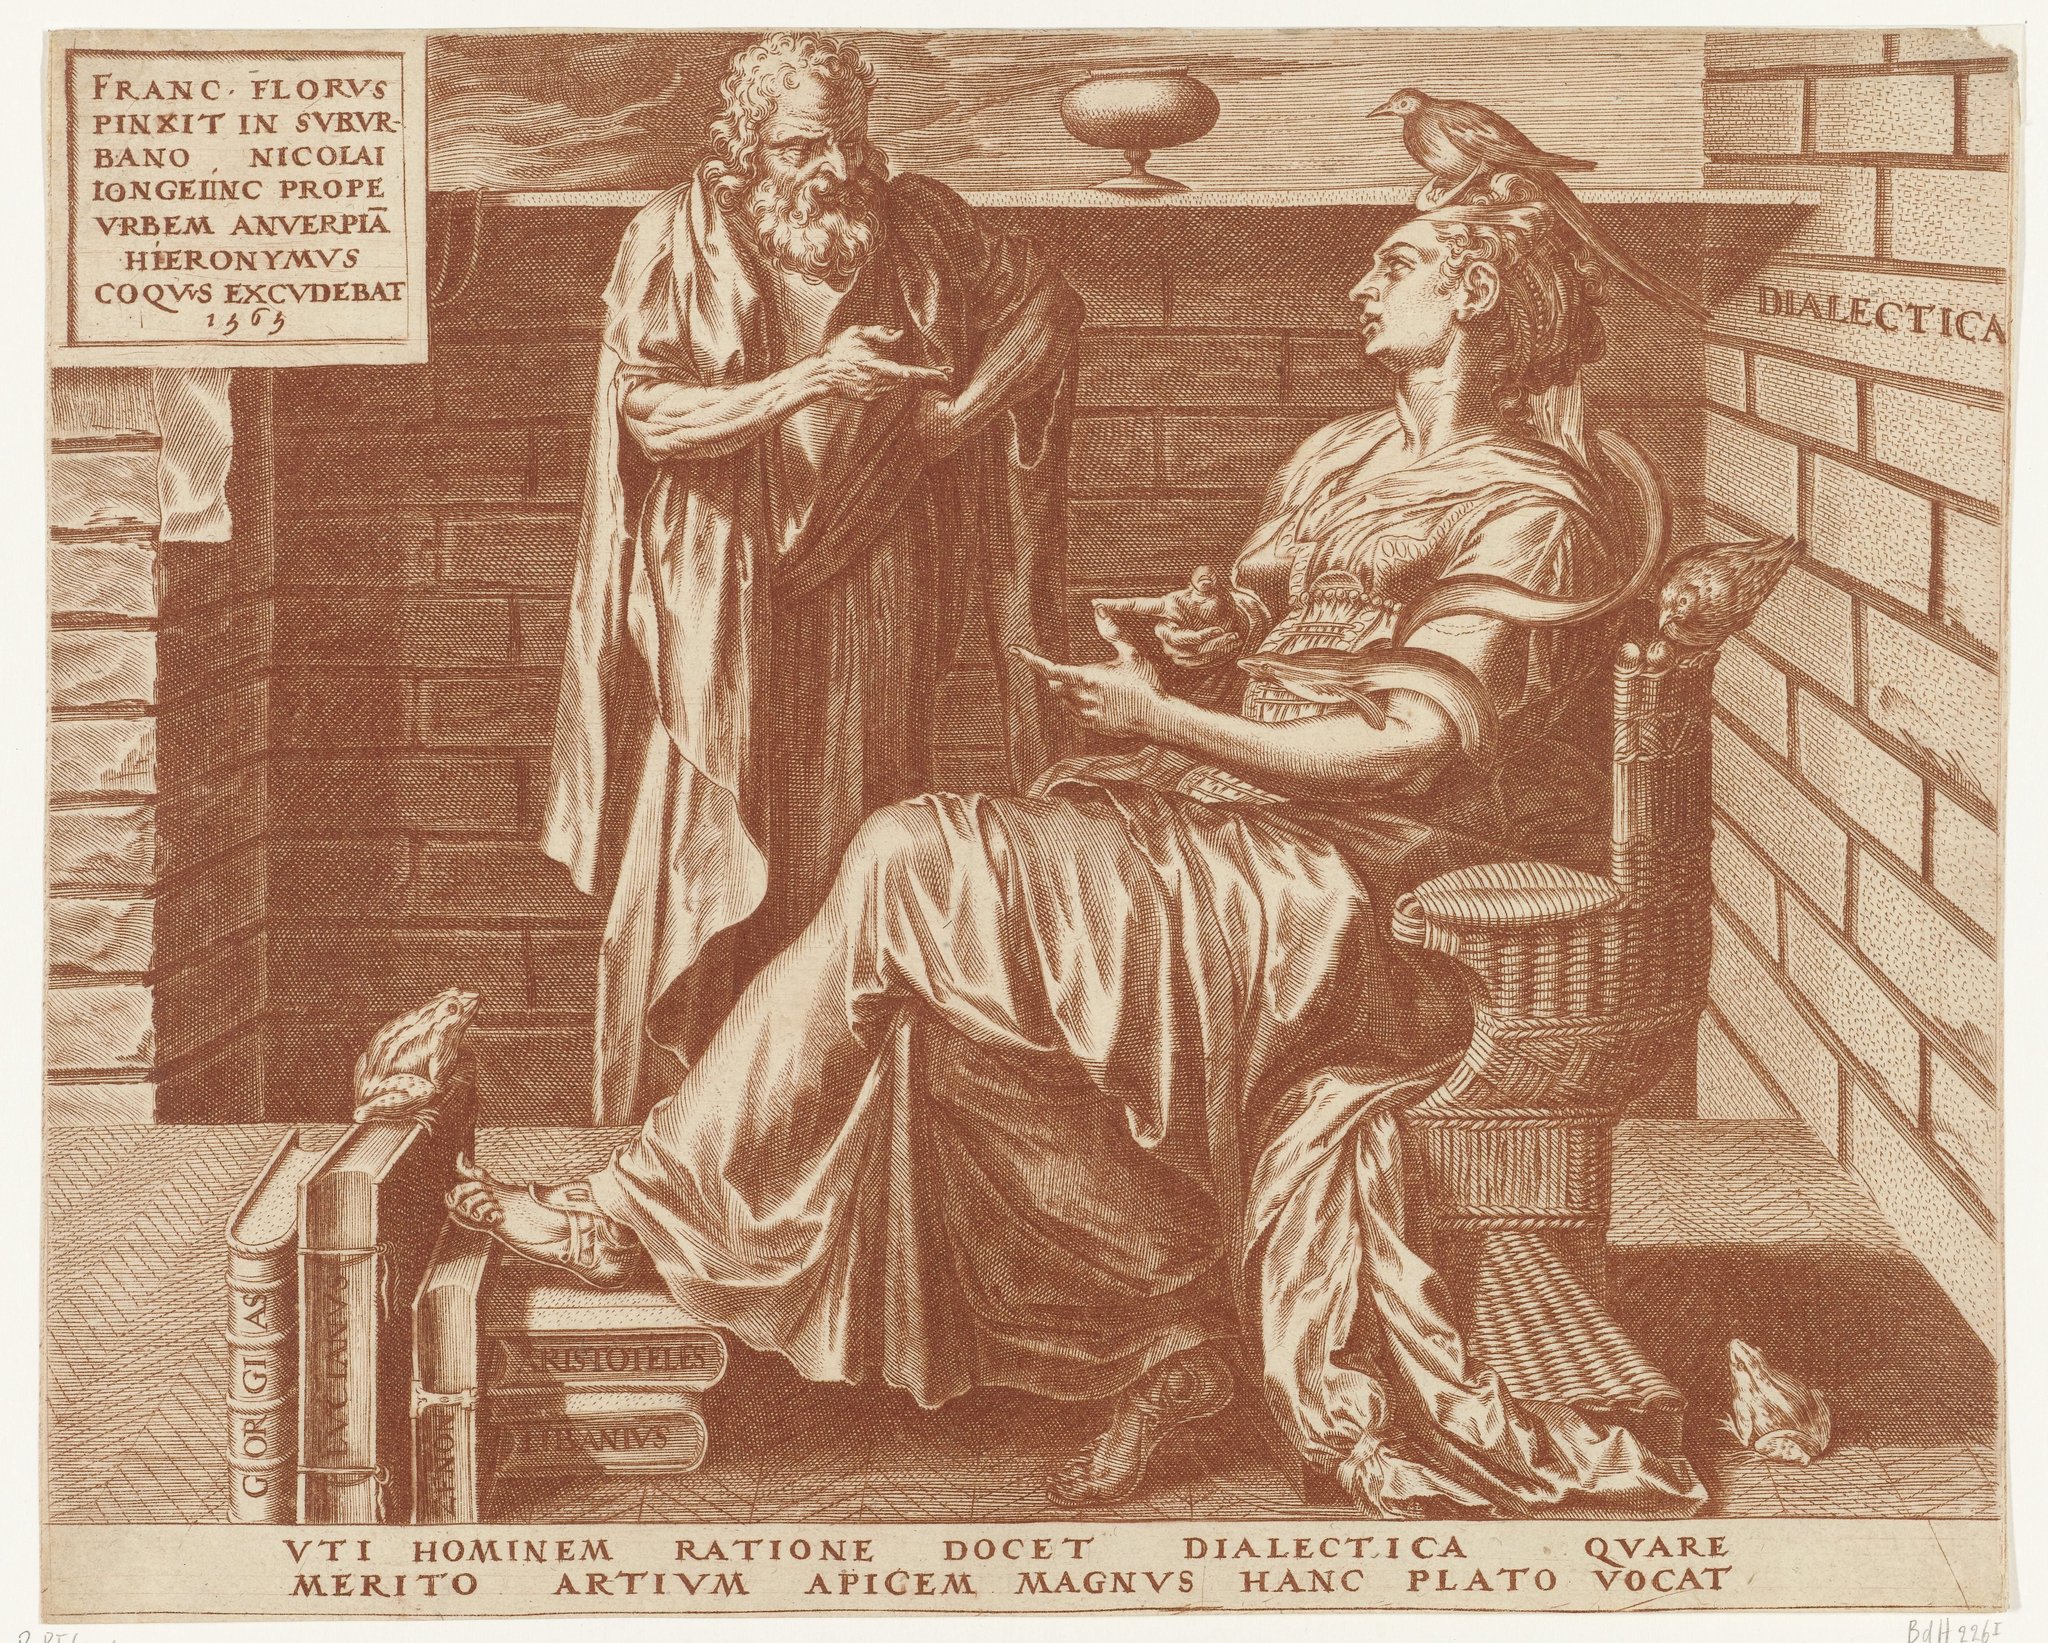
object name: print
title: Dialectica (Redeneerkunst)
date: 1565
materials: paper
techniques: printing, engraving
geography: antwerp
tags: 'dialectica' (~ trivium); 'dialettica' (ripa)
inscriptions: collector's mark: Lugt 240, caption:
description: Dialectica zit op een stoel in een ruimte met stenen muren en disputeert met een oude man. Ze telt haar argumenten aan de vingers af. Op haar hoofd en op de leuning van haar stoel zitten vogels, op de grond twee padden. Dialectica staat met haar voet op een stapel boeken van belangrijke denkers.